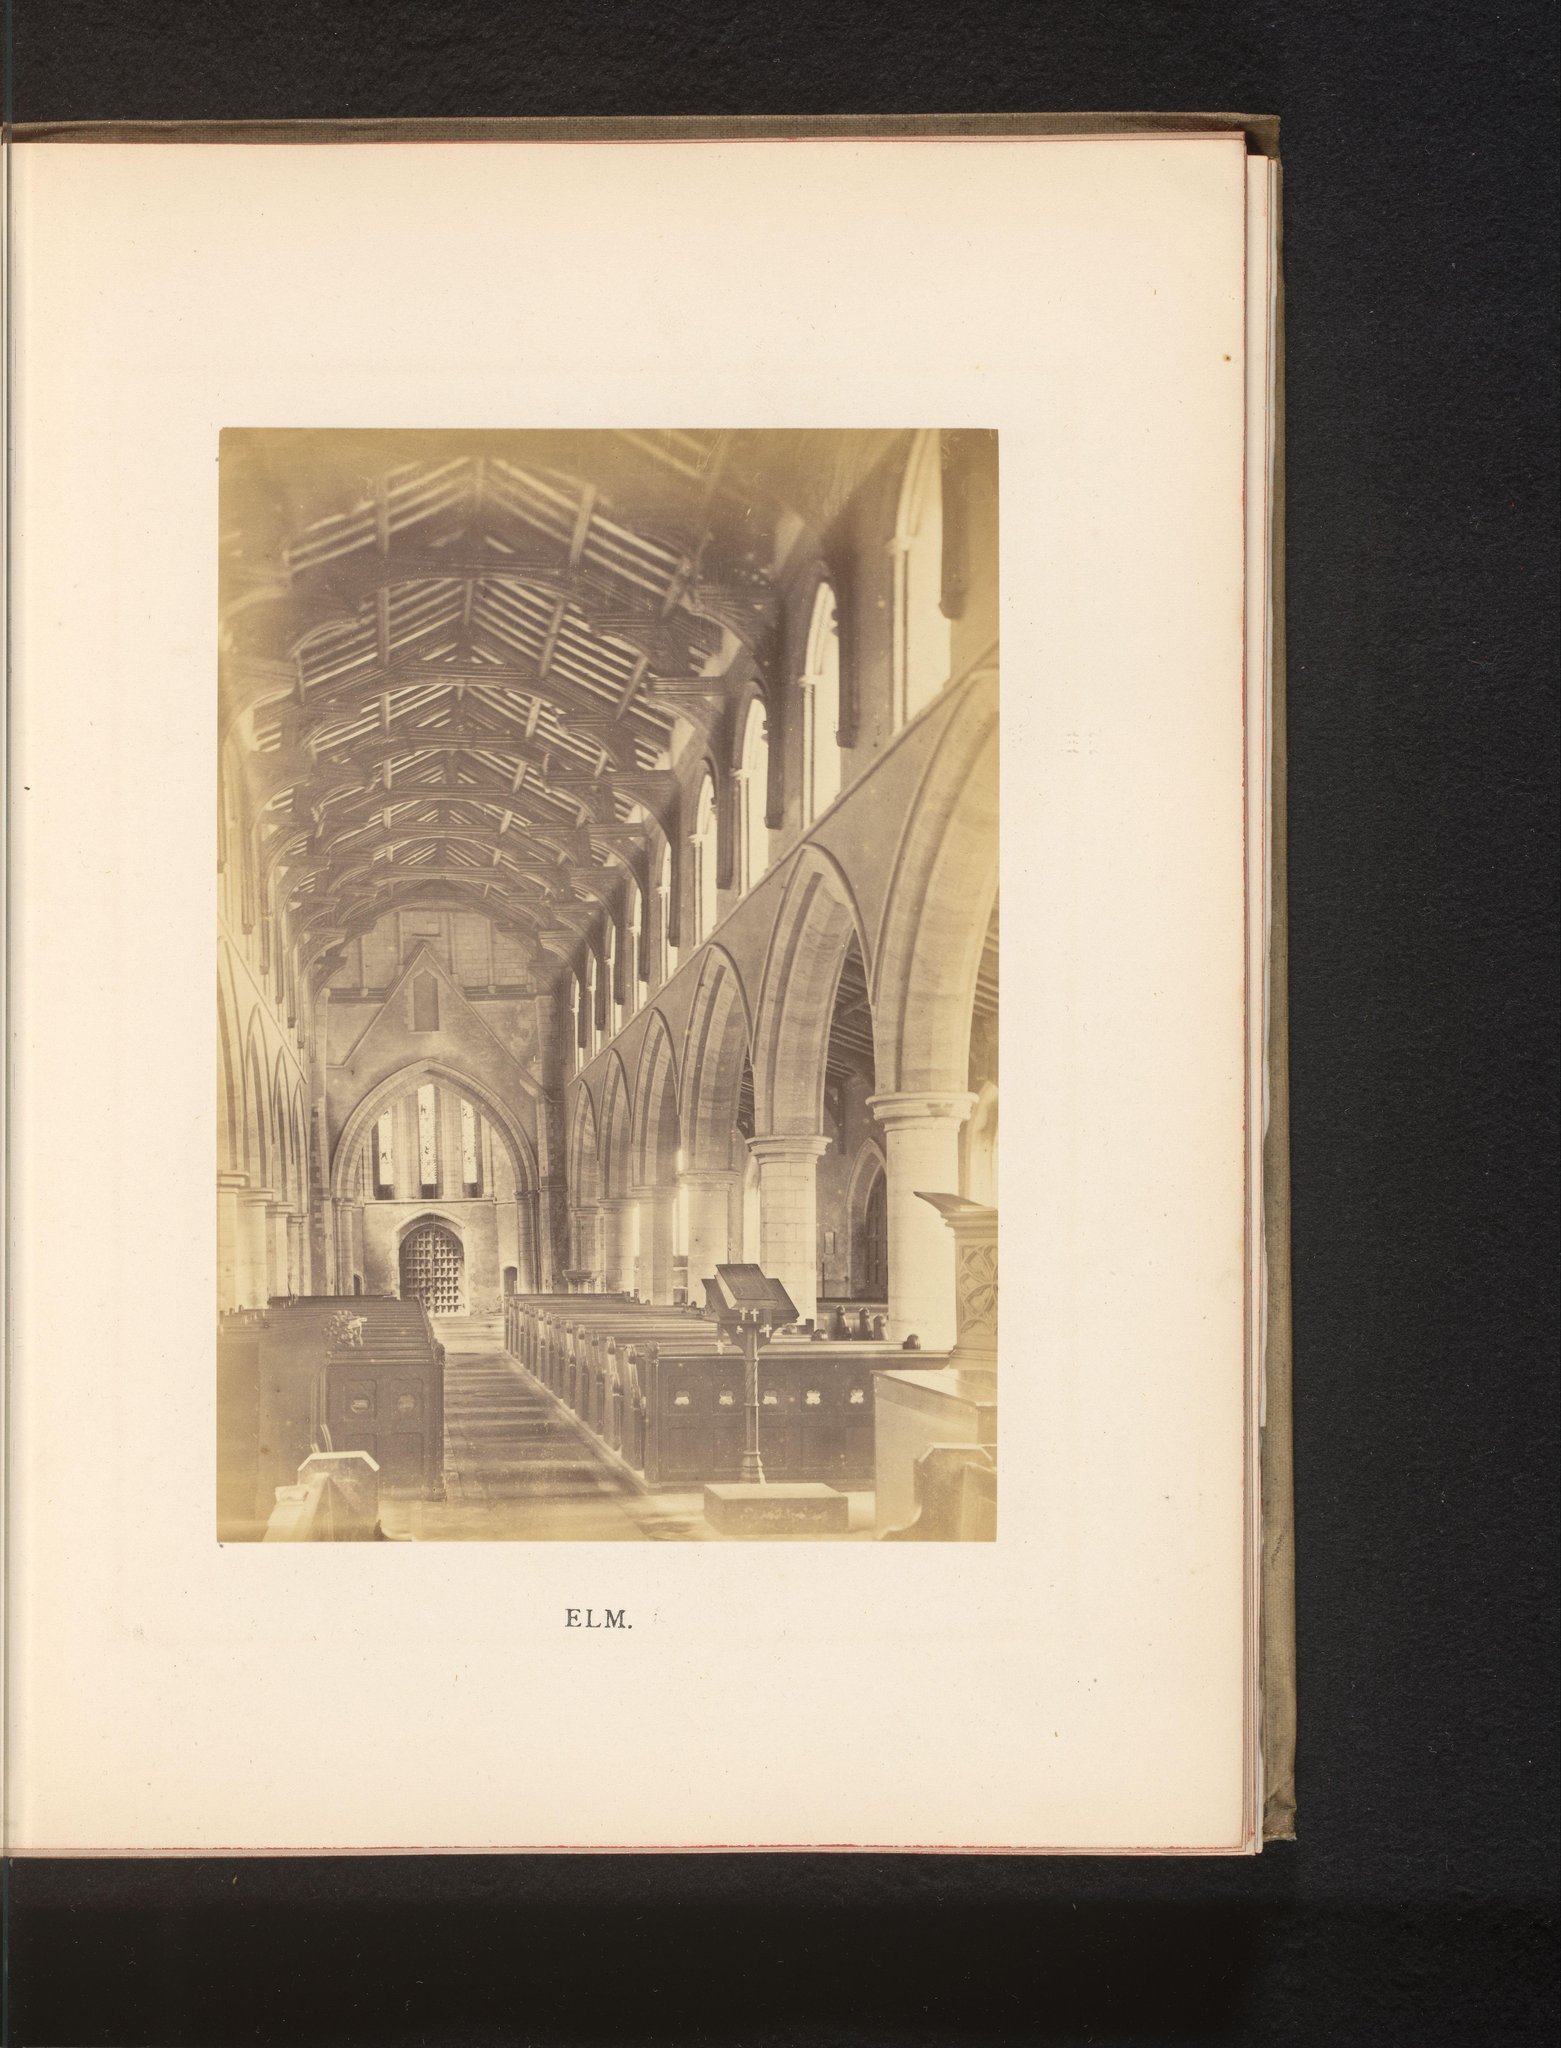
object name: page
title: Elm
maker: Anonymous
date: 1858-1869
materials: photographic support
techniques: albumen print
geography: elm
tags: parts of church interior: aisle, interior of church